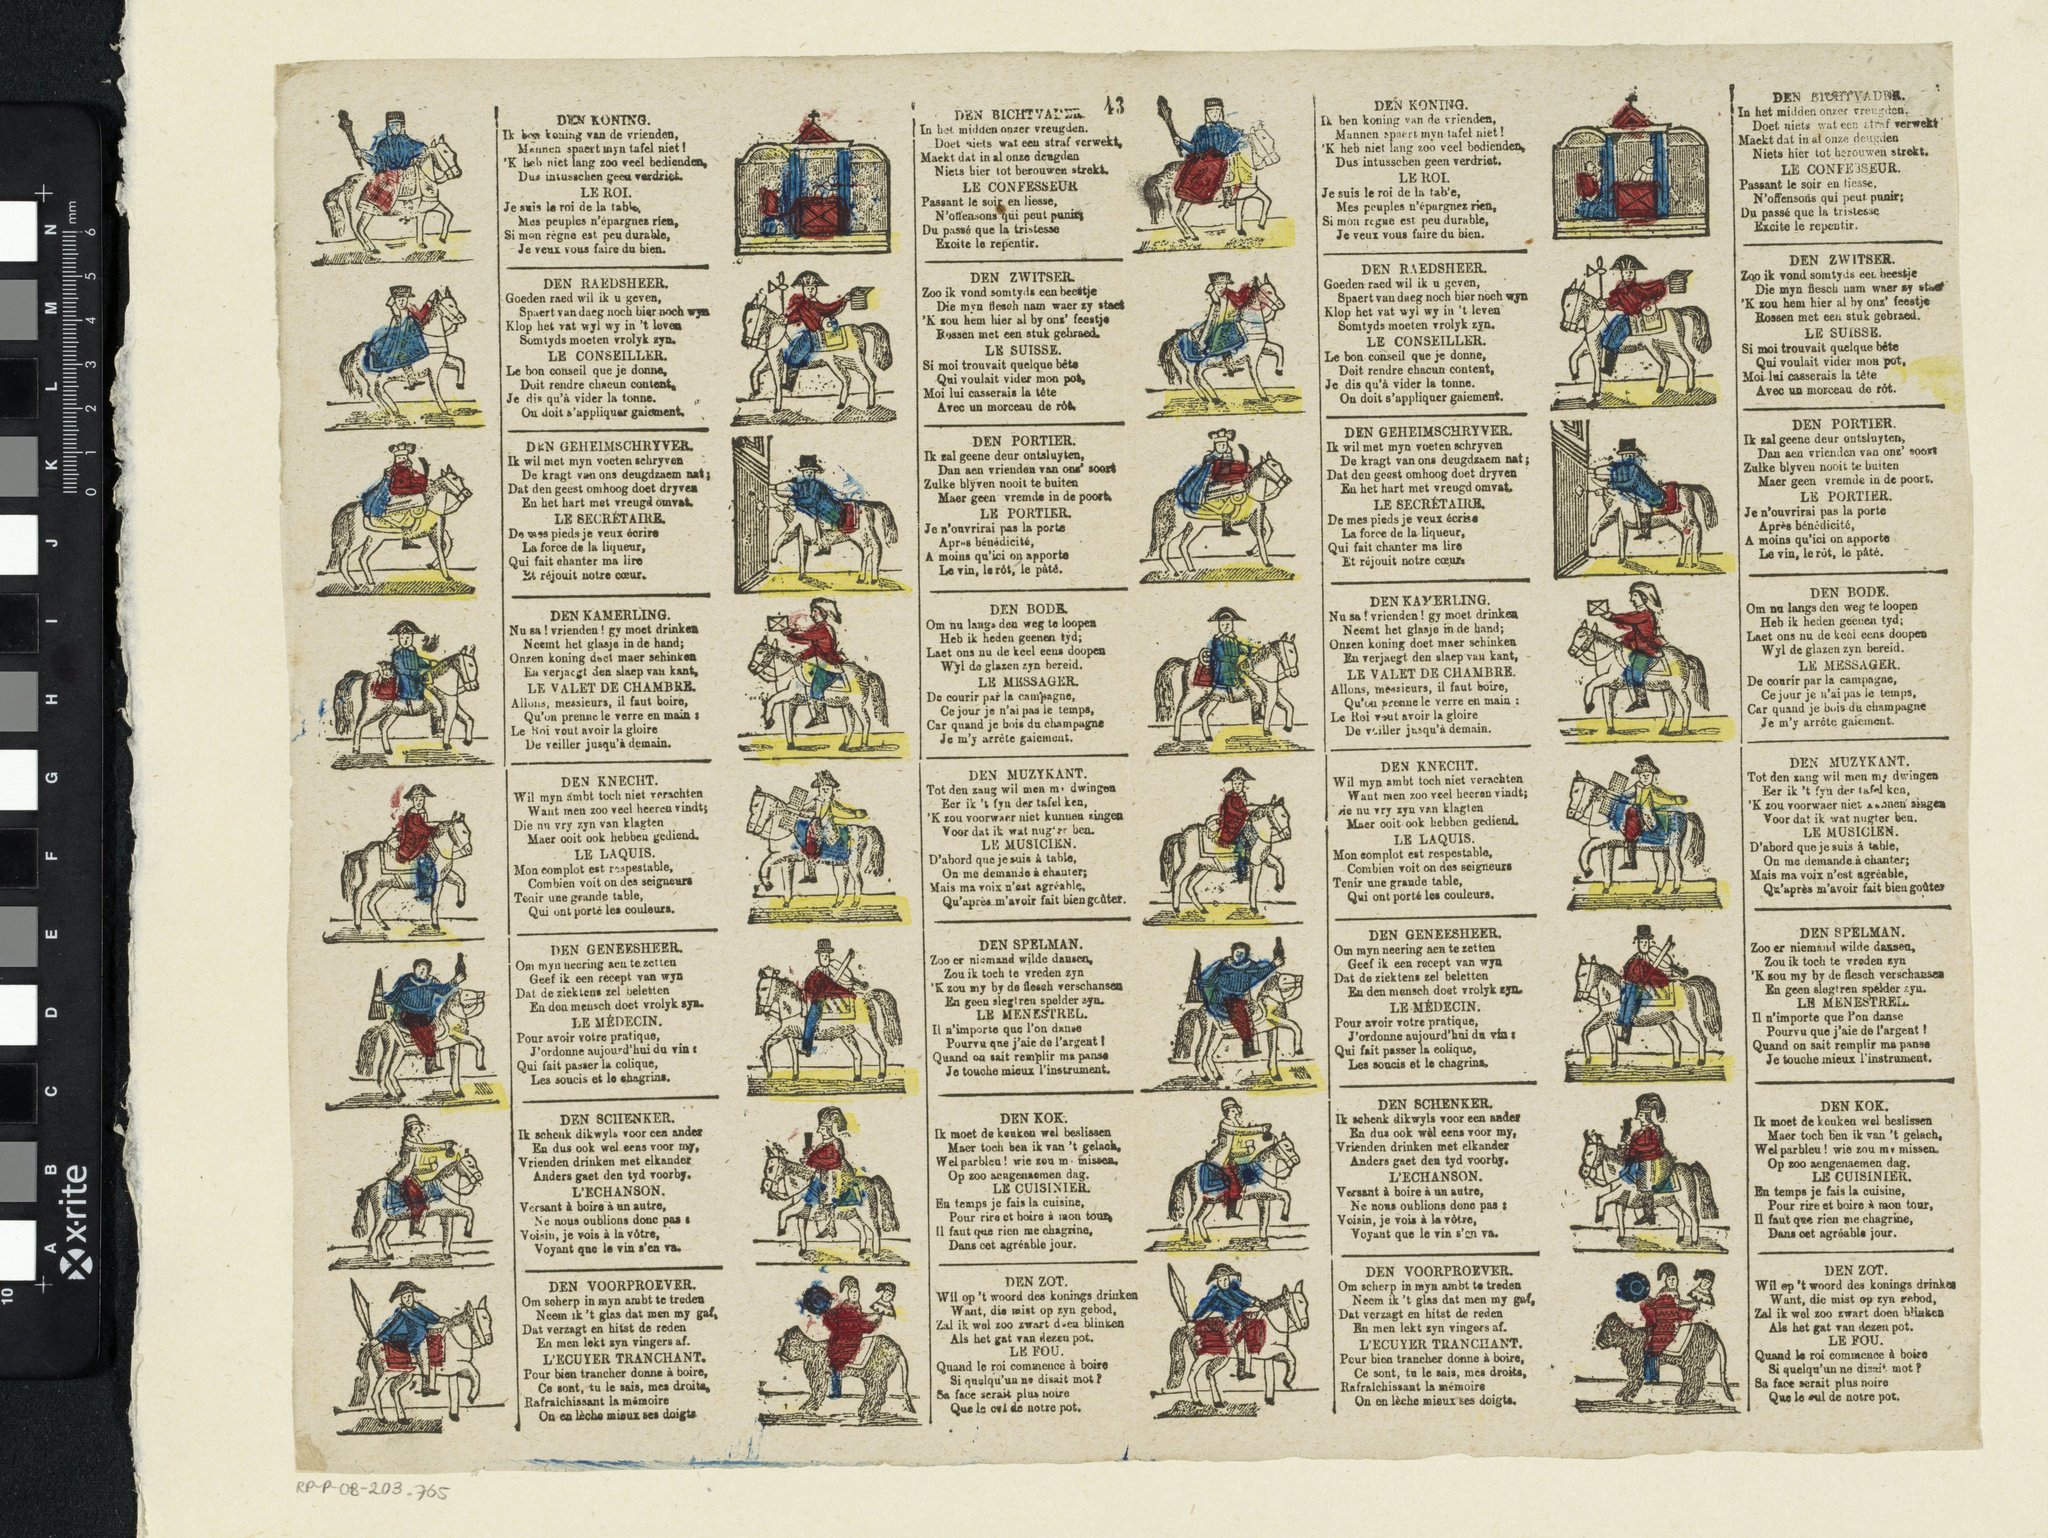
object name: print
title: Driekoningenbriefjes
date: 1827-1894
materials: paper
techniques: colour, letterpress printing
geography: schaarbeek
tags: twelfth night, usually falling on the eve of january 6, royal household; courtiers, retinue, train, epiphany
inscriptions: collector's mark: Lugt 2760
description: Blad met 32 voorstellingen (driekoningenbriefjes) van verschillende functies binnen het hof, waaronder een raadsman, een proever en een portier. Rechts naast elke afbeelding een vierregelig vers in het Nederlands en in het Frans. Genummerd midden boven: 43.